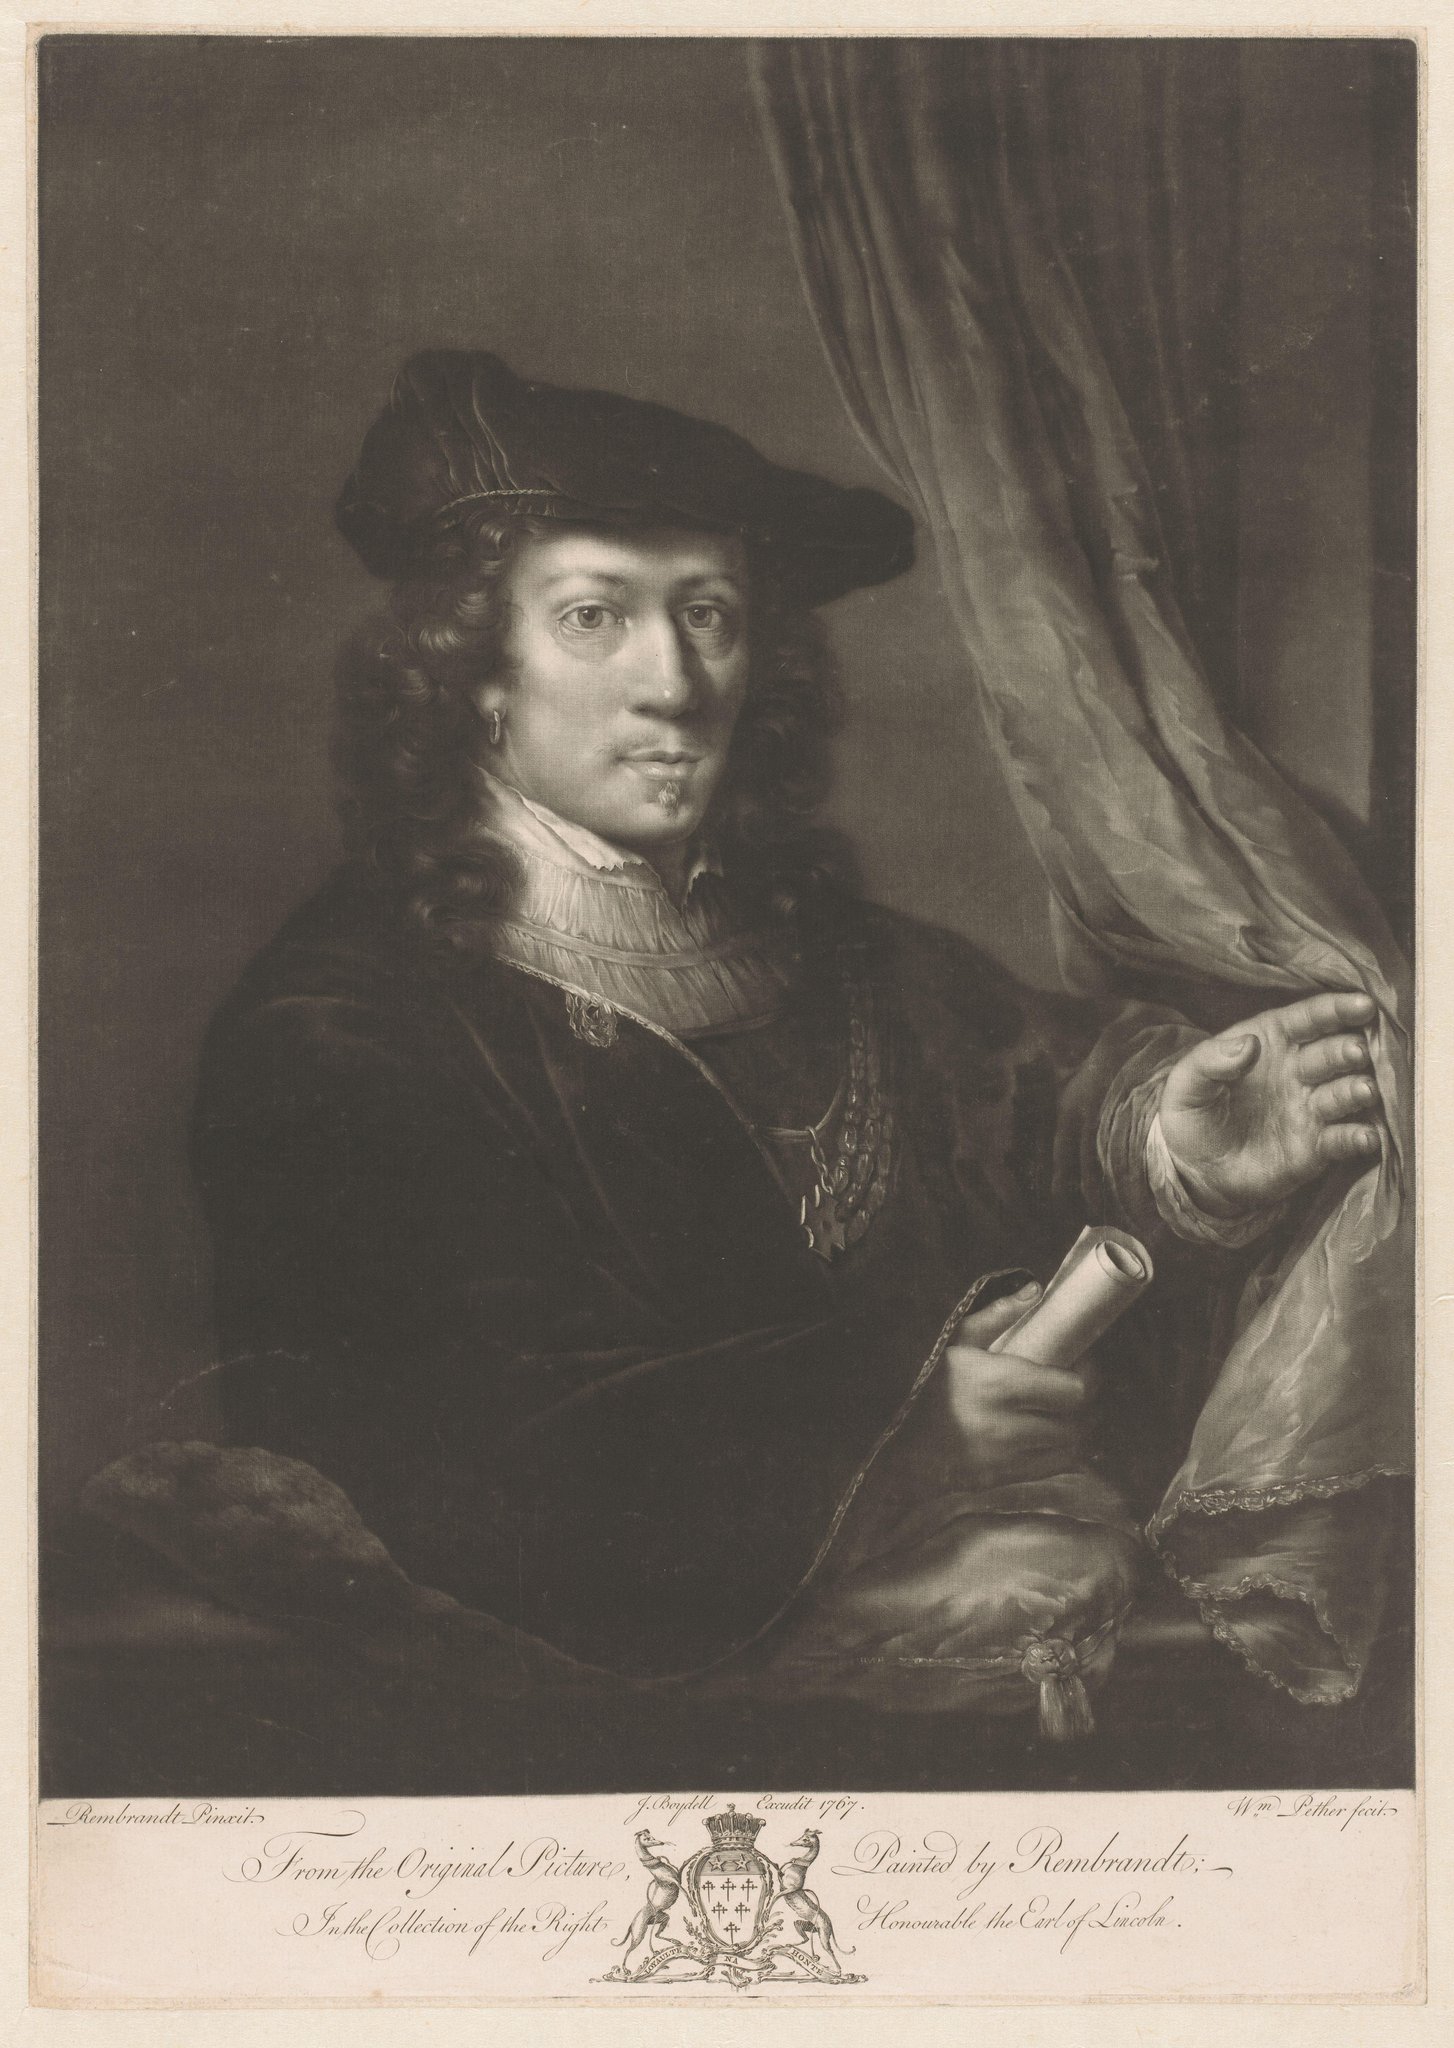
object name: print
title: Portret van een onbekende man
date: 1767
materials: paper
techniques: mezzotint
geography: london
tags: historical persons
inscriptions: collector's mark: Lugt 2233